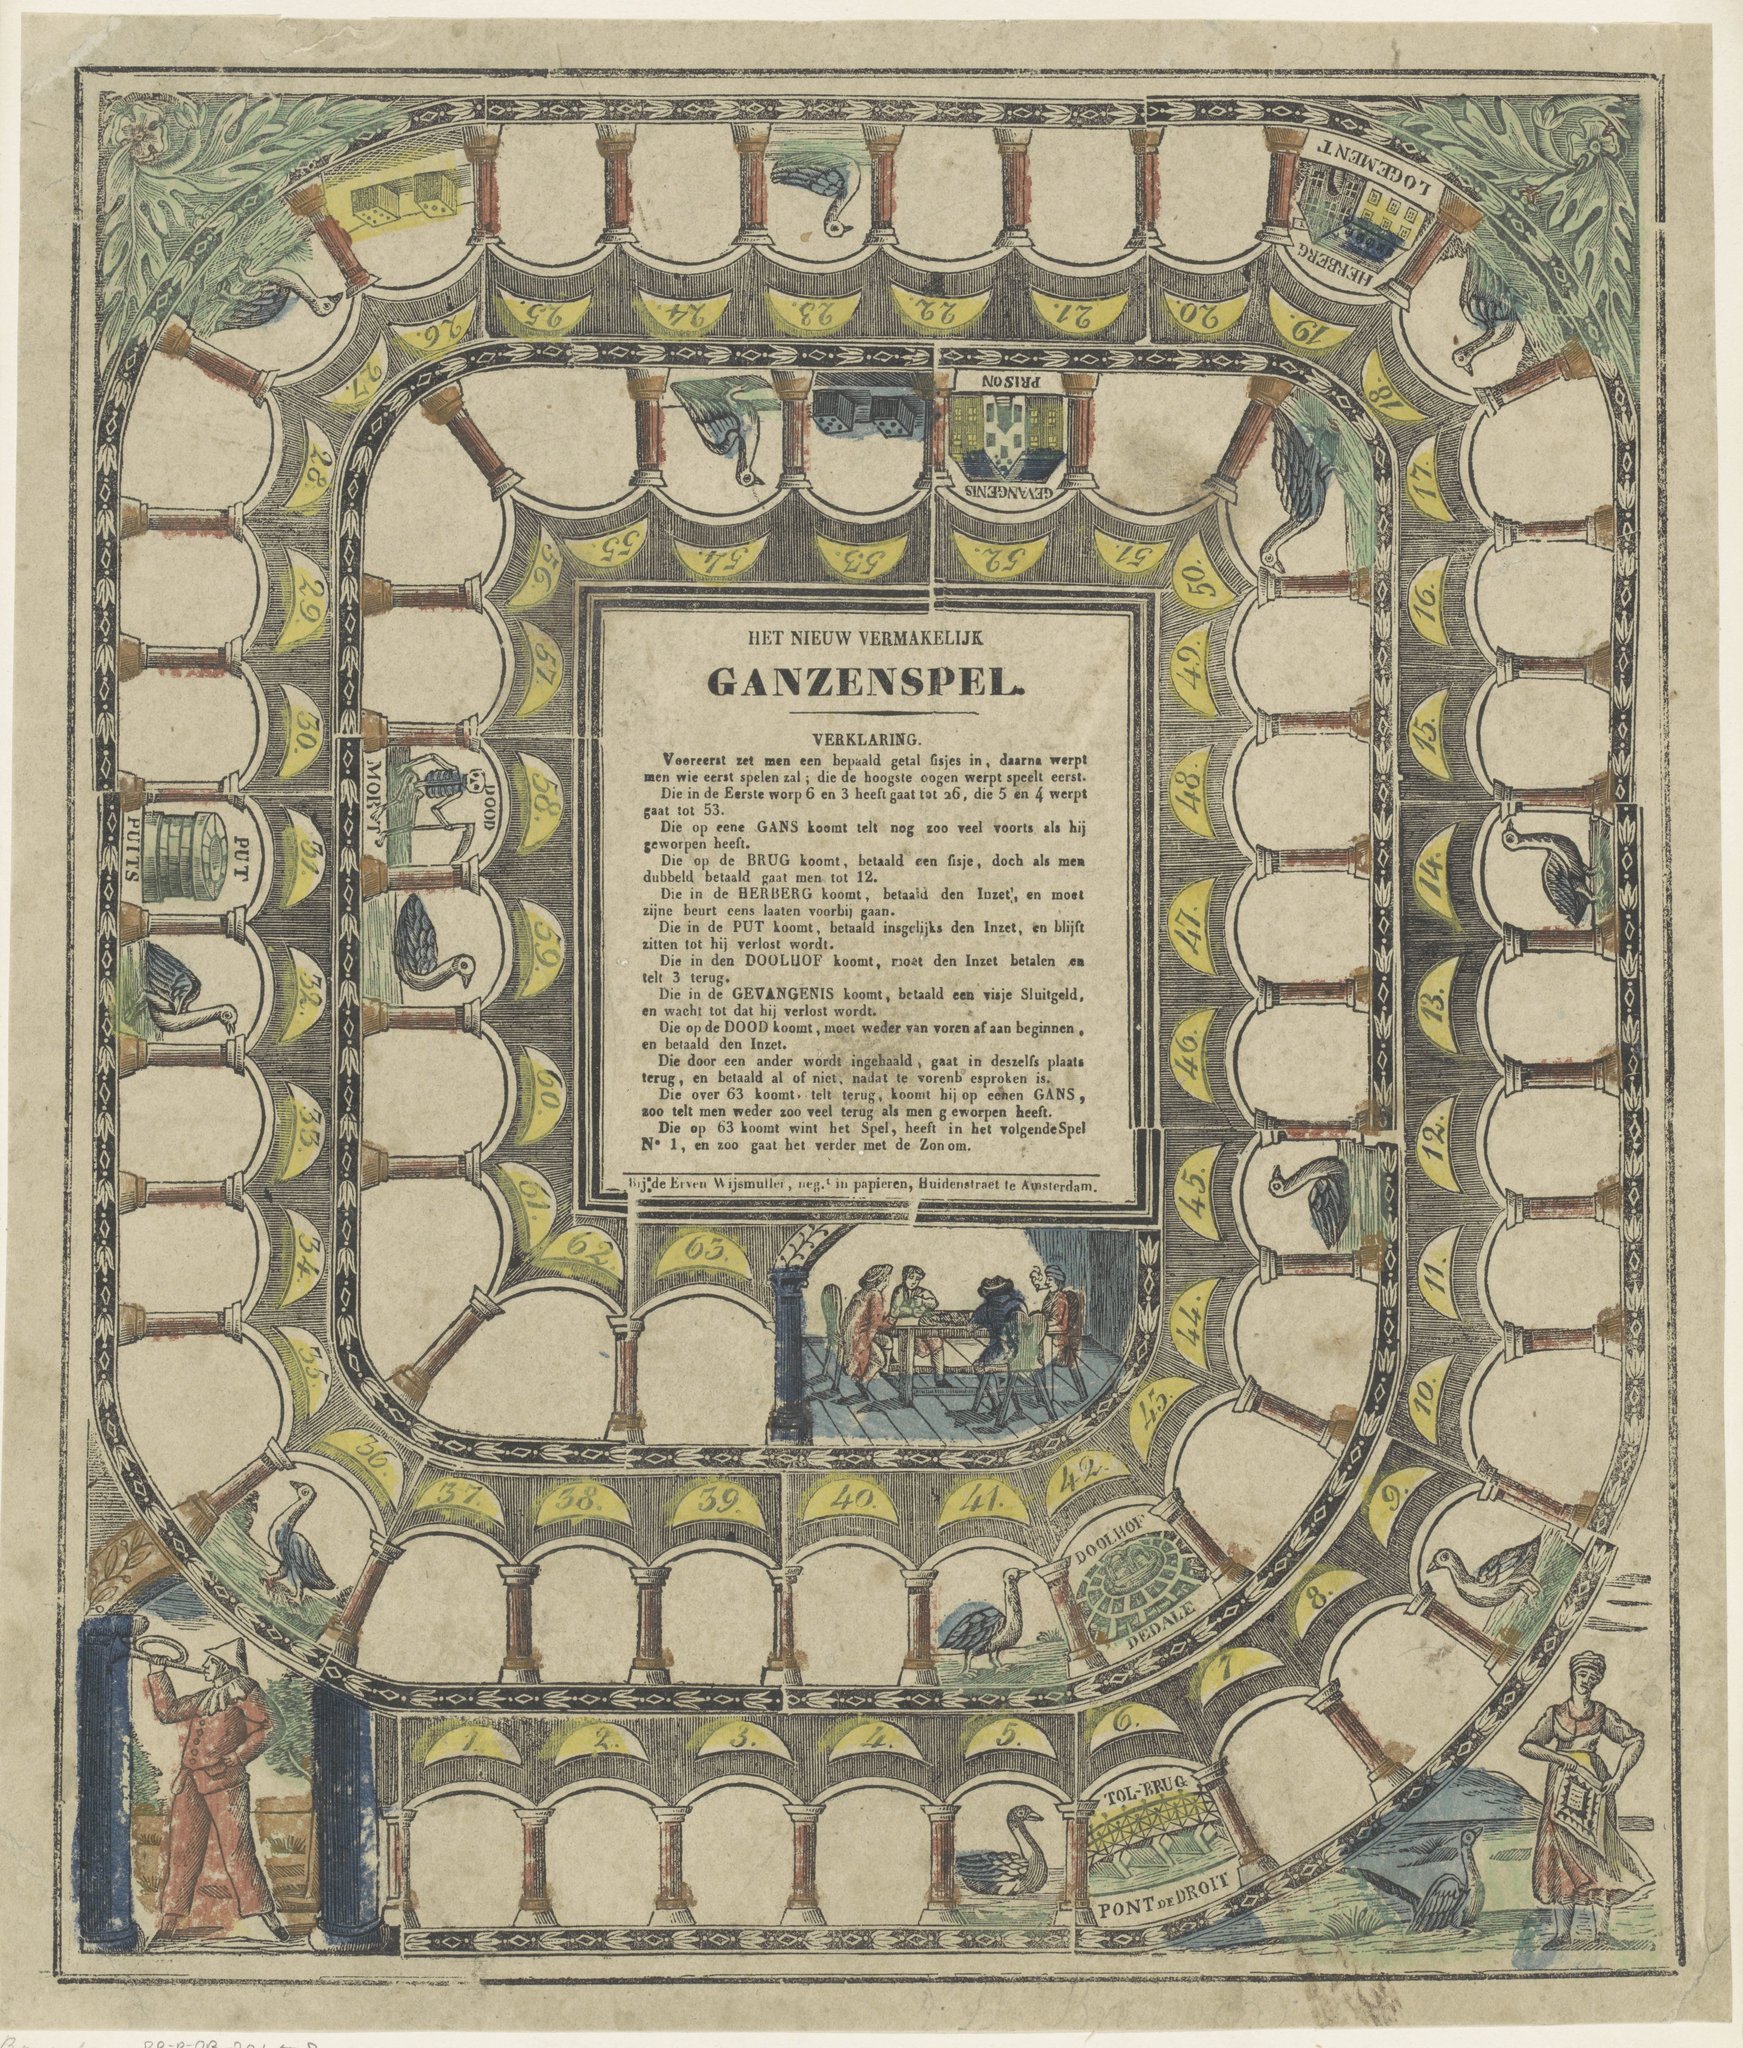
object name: gameboard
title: Het nieuw vermakelijk / ganzenspel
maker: Anonymous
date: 1828-1933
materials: paper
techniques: colour, letterpress printing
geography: amsterdam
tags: goose-game, board-games of chance, board-games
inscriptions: collector's mark: Lugt 2760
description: Ganzenbordspel met spiraal met 63 genummerde vakjes. In verschillende vakjes een voorstelling van een gans. Op het middenveld de titel en spelregels in boekdruk.